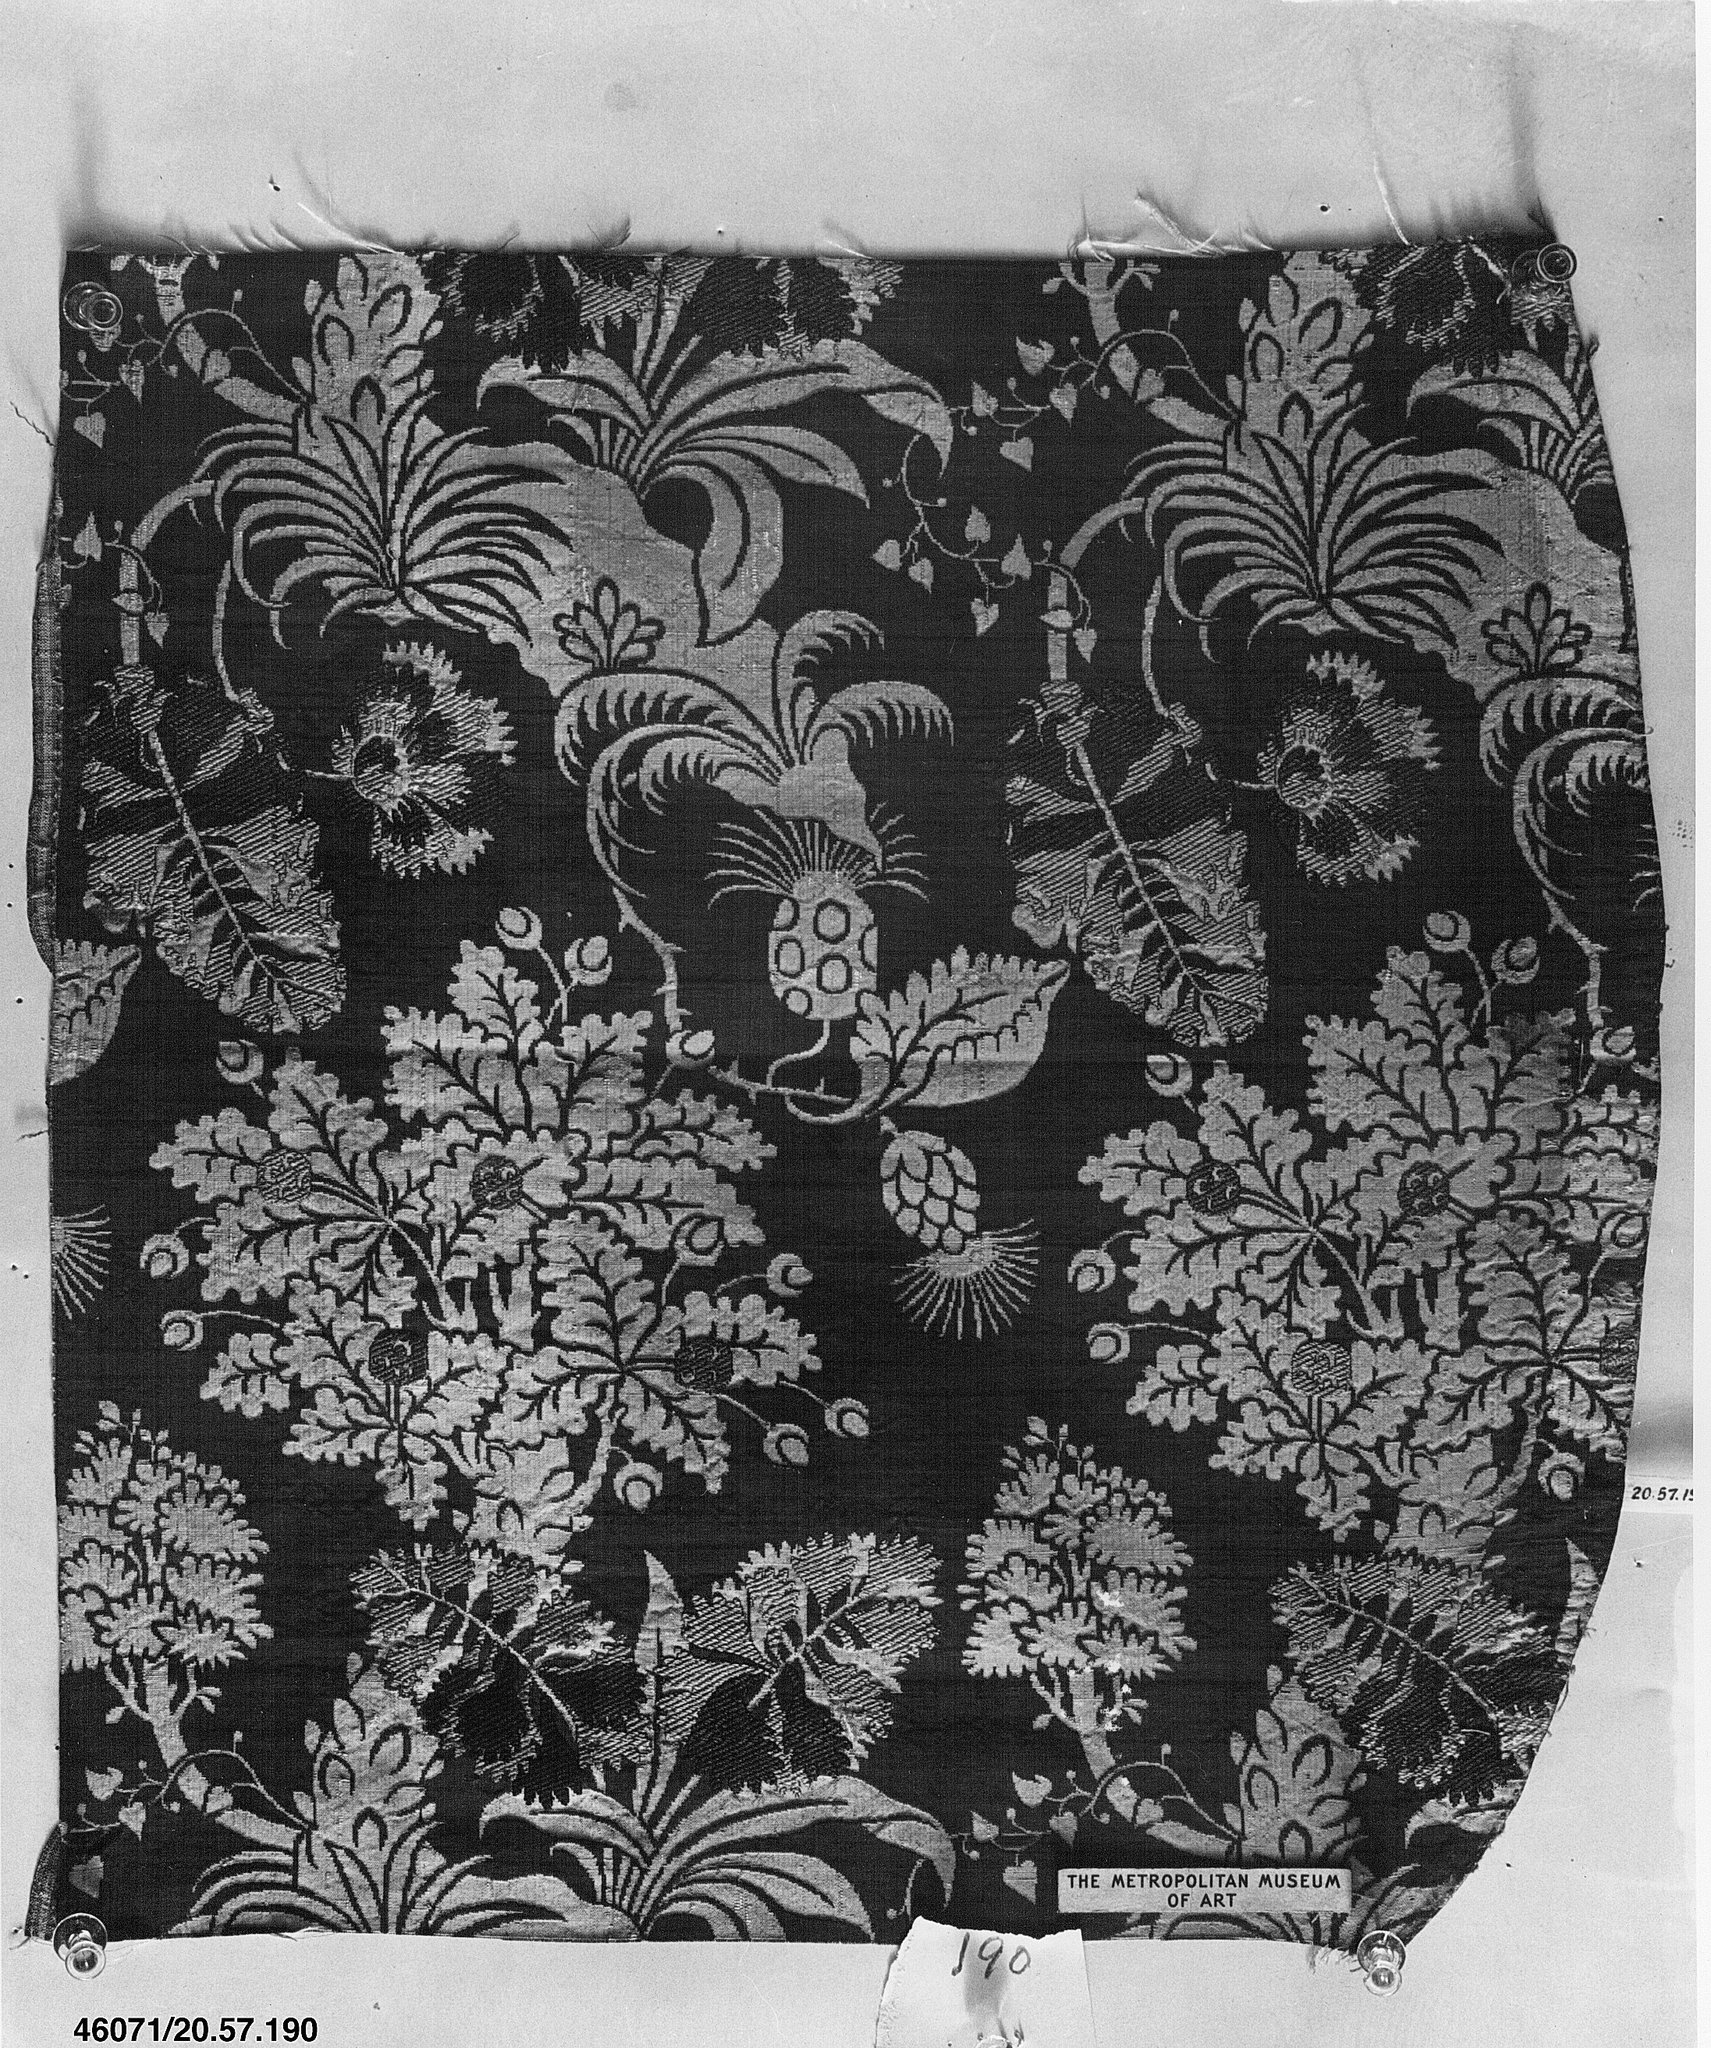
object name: piece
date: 1730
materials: silk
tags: leaves